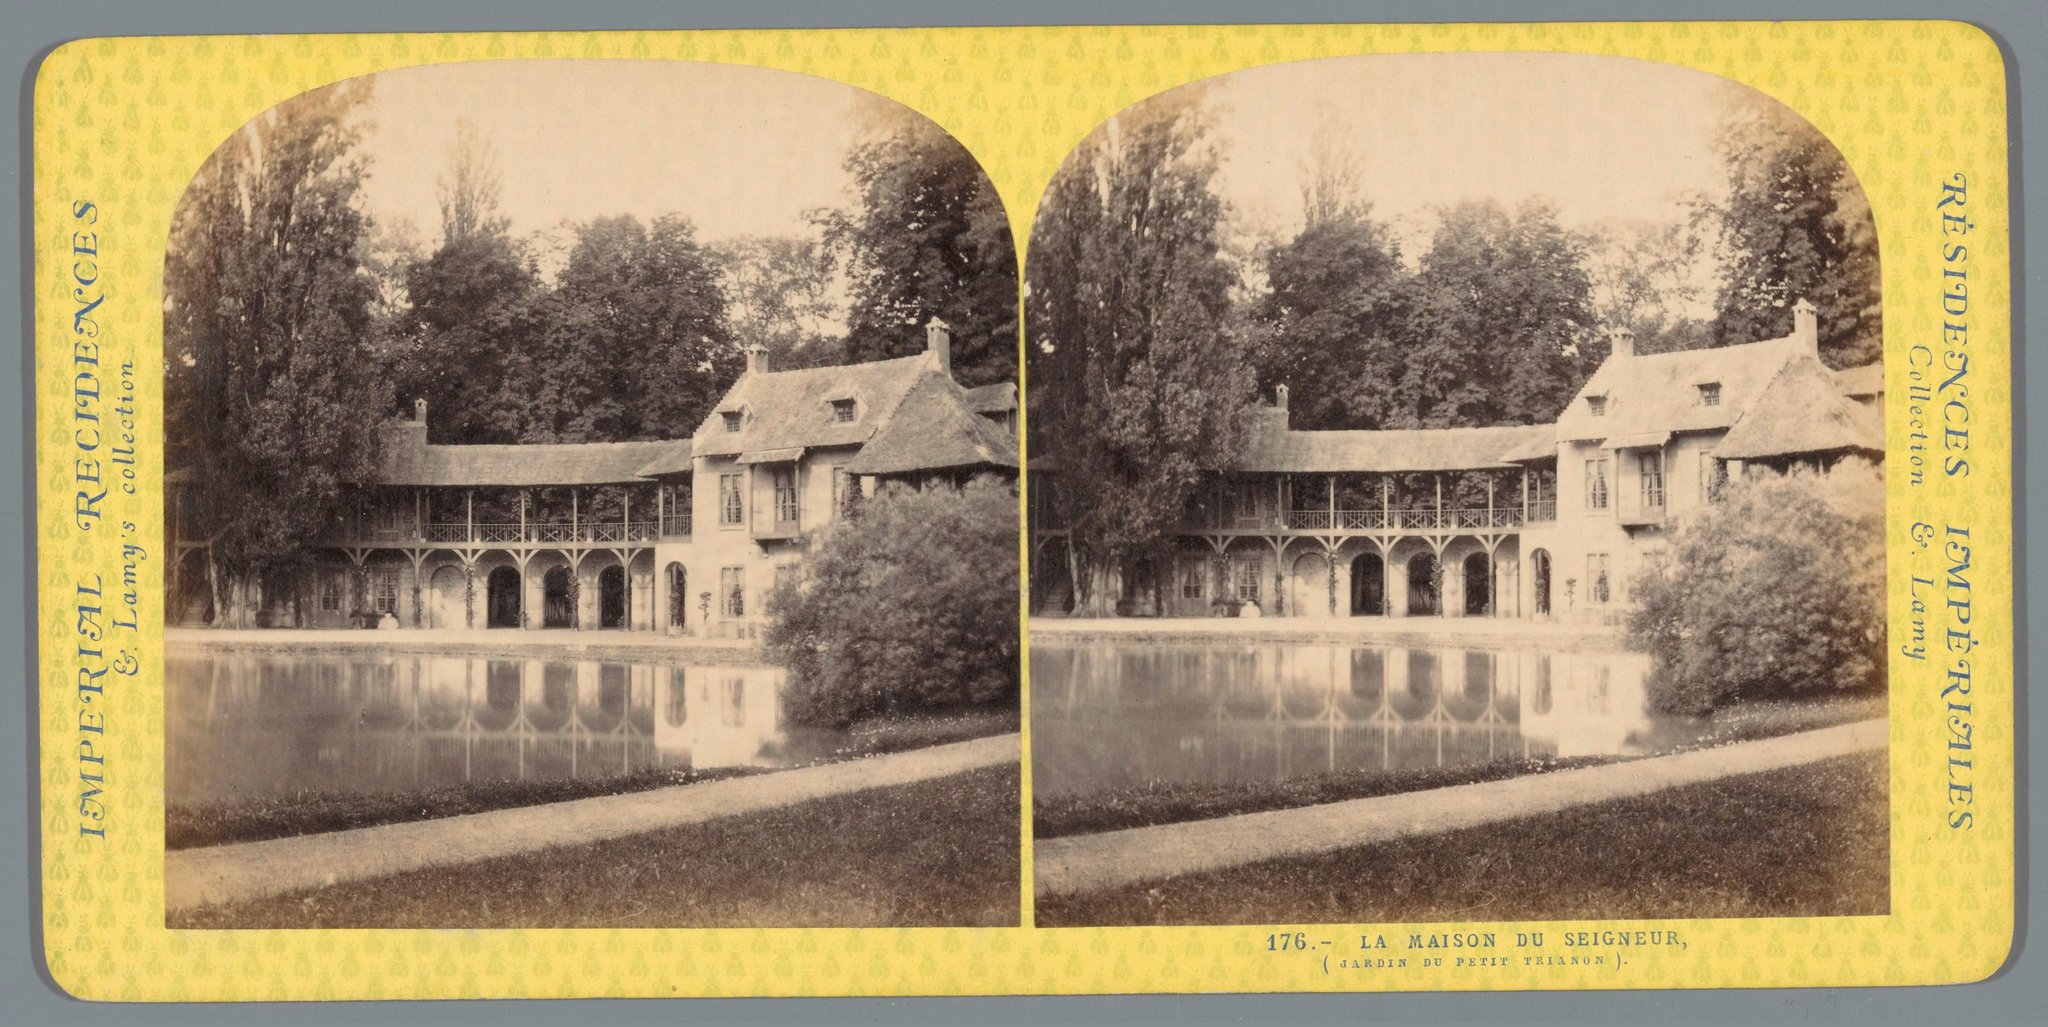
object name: stereograph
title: Maison de la reine in Le Hameau de la Reine bij het Petit Trianon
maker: ernest eléonor pierre lamy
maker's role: publisher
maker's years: 1828-1900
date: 1860-1880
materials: cardboard, photographic support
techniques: albumen print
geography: le hameau de la reine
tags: garden, country-house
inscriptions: number: ‘176.’, inscription: ‘E. Lamy's collection’